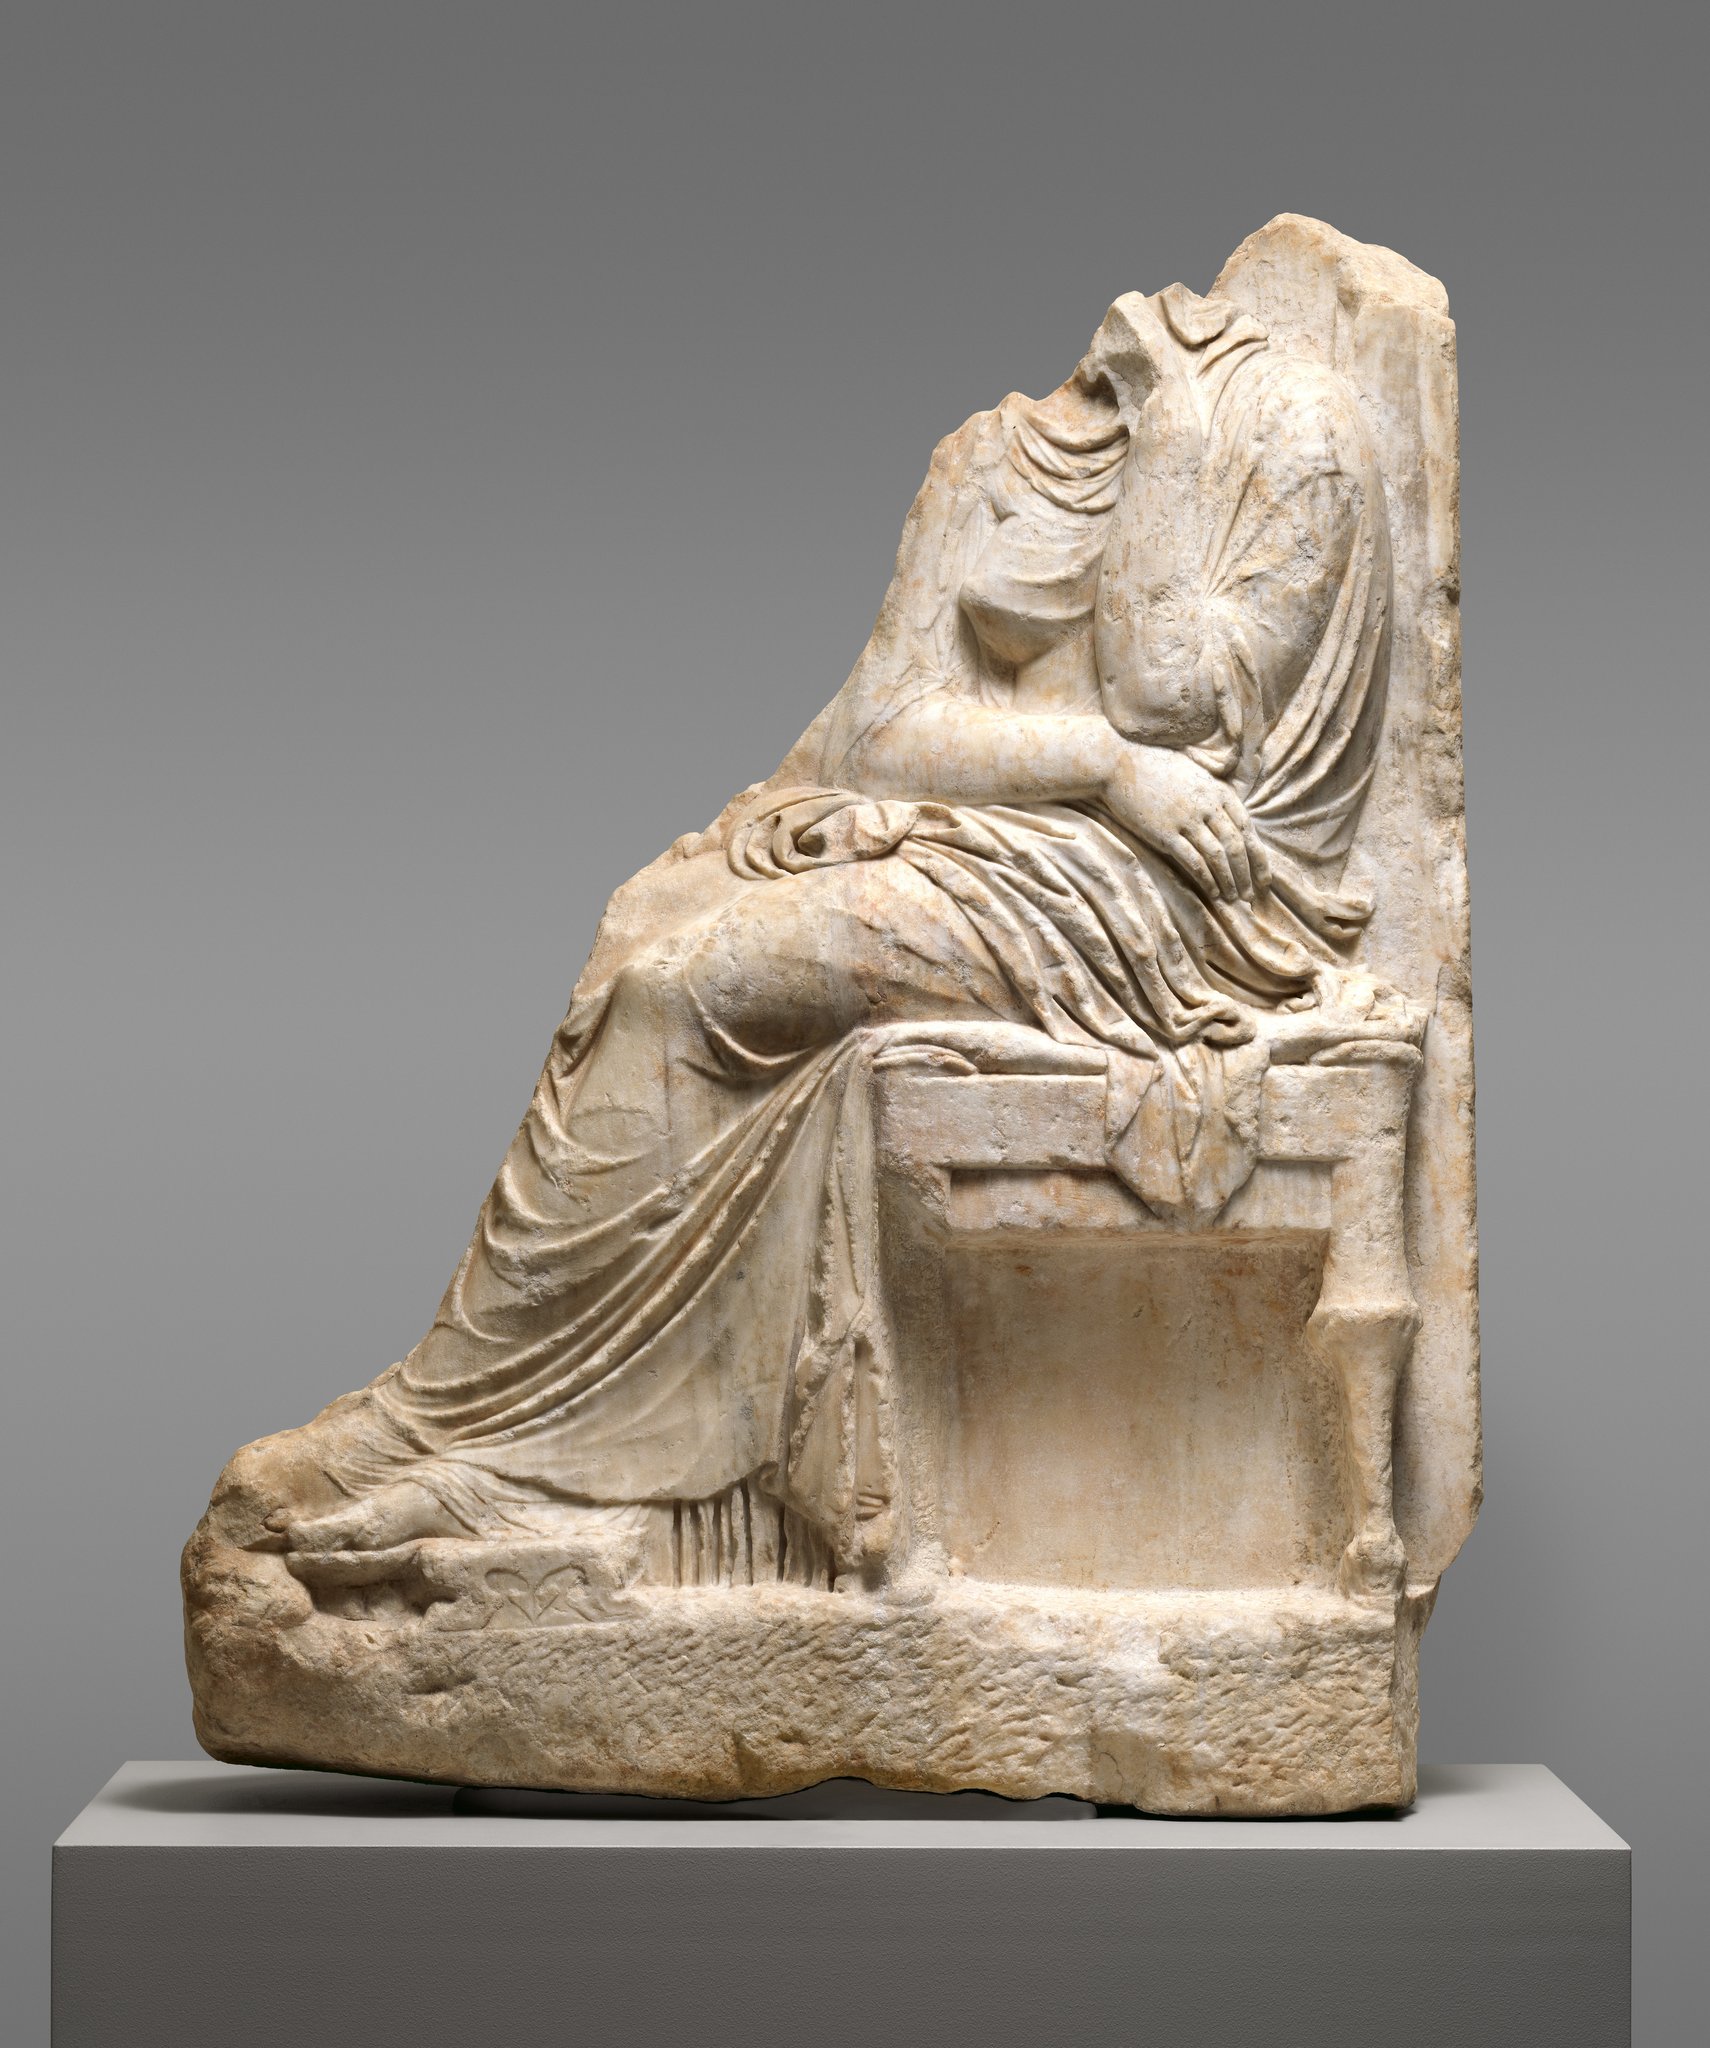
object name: grave stele fragment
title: Fragment of a marble stele (grave marker)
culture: greek, attic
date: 400-375 BCE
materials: marble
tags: women,stools